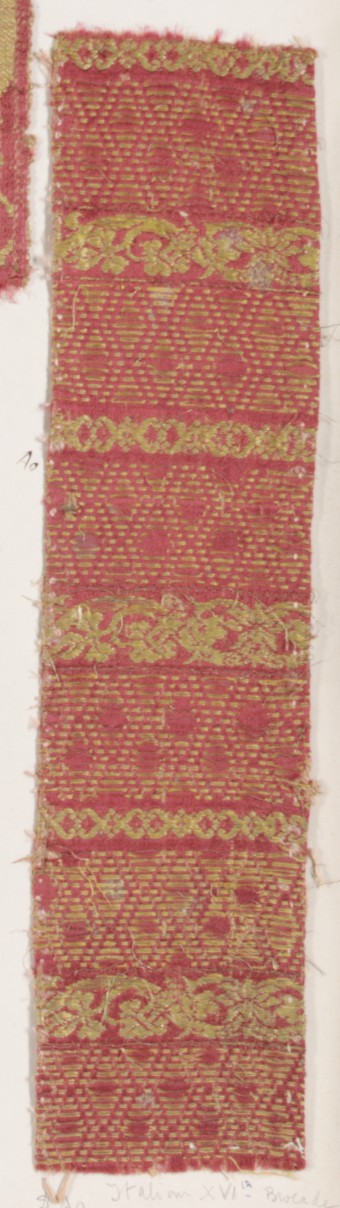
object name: fragment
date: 1501-1600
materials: metal thread, silk